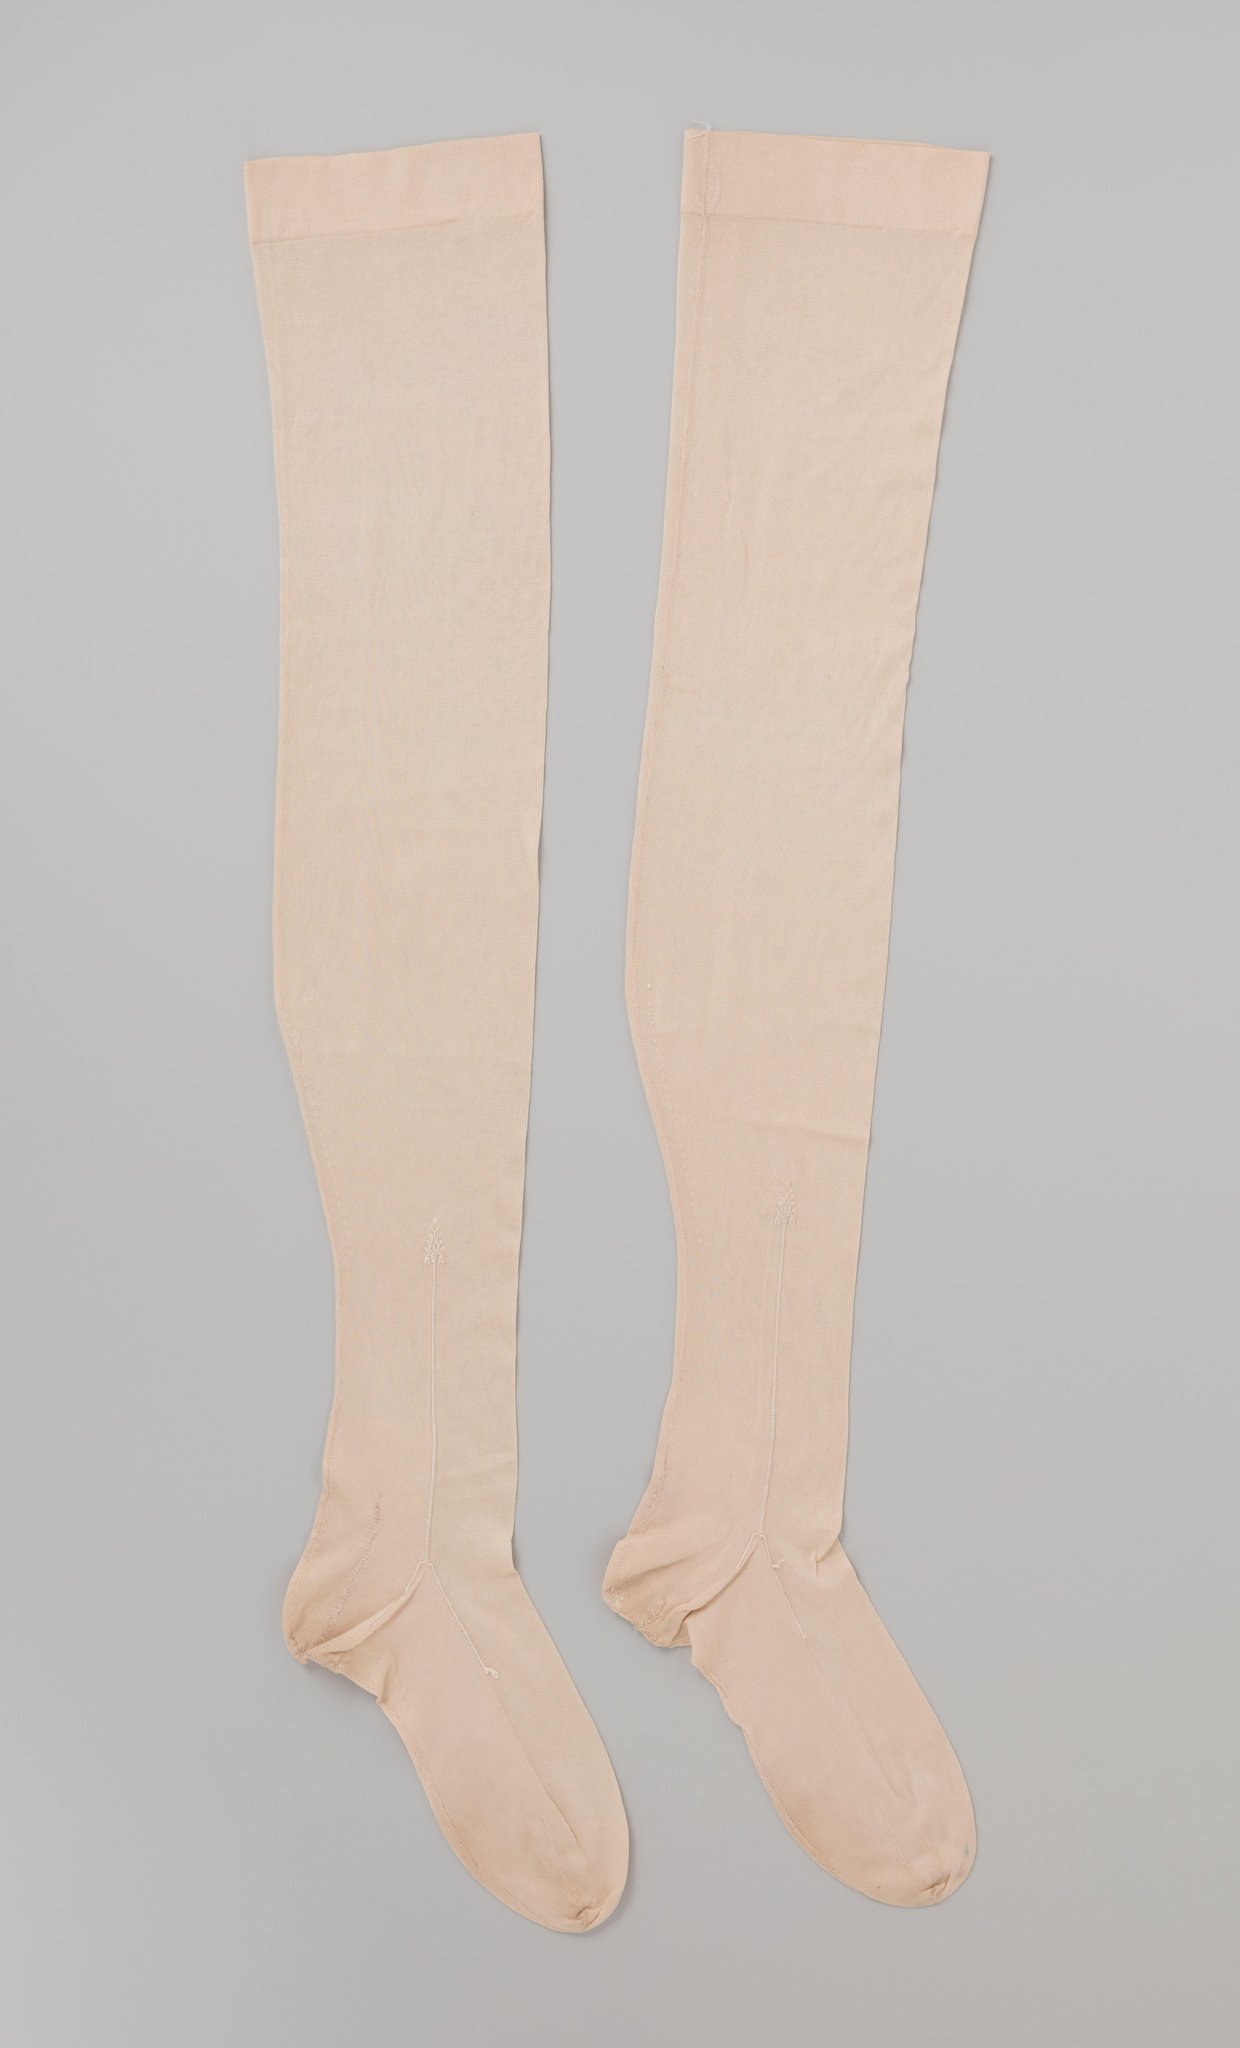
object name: stocking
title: Kous van effen ivoorkleurige zijde met een enkele geborduurde pijl op de klink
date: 1800-1820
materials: silk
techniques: embroidered, knitting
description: Kous van effen ivoorkleurige zijde met een enkele geborduurde pijl op de klink. Naad middenachter.